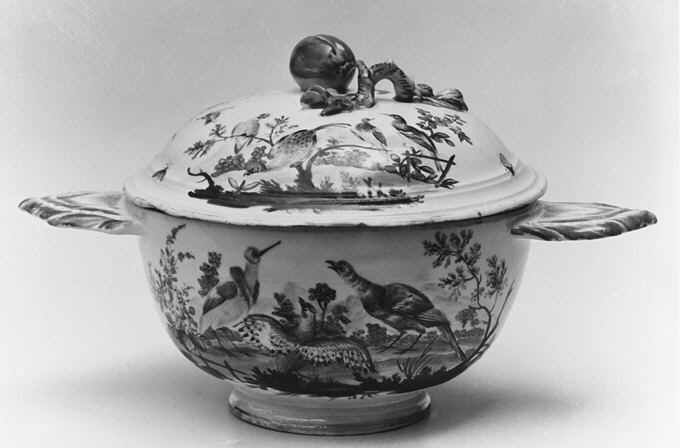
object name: bowl with cover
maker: sceaux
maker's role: factory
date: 1772-1793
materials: creamware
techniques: glazing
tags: birds,trees